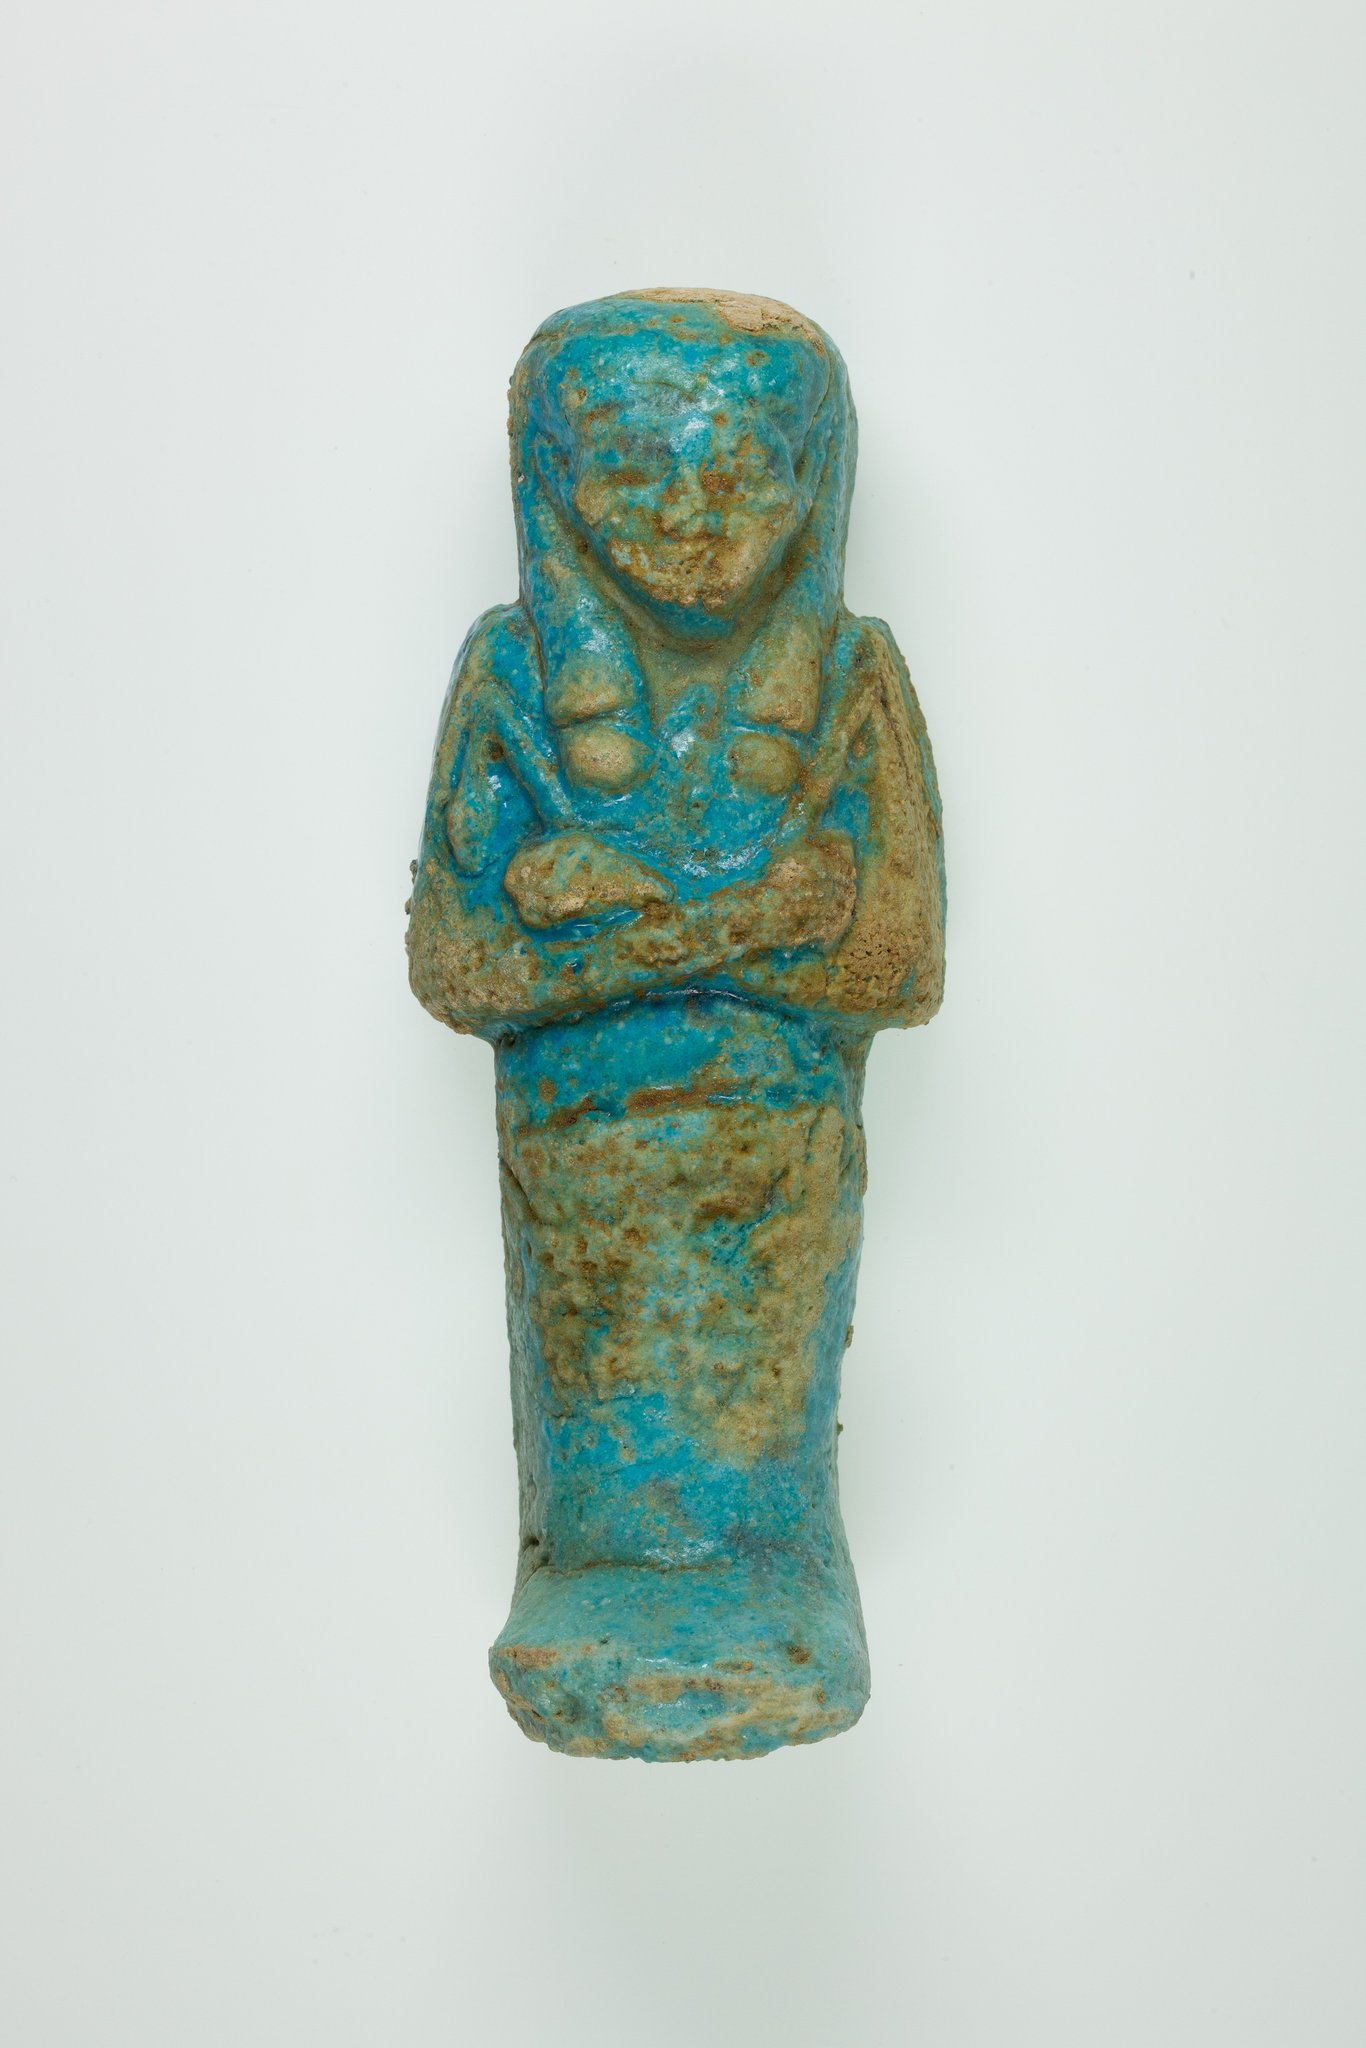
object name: worker shabti, henettawy c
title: Worker Shabti of Henettawy (C), Daughter of Isetemkheb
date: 990-970 BCE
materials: faience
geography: egypt